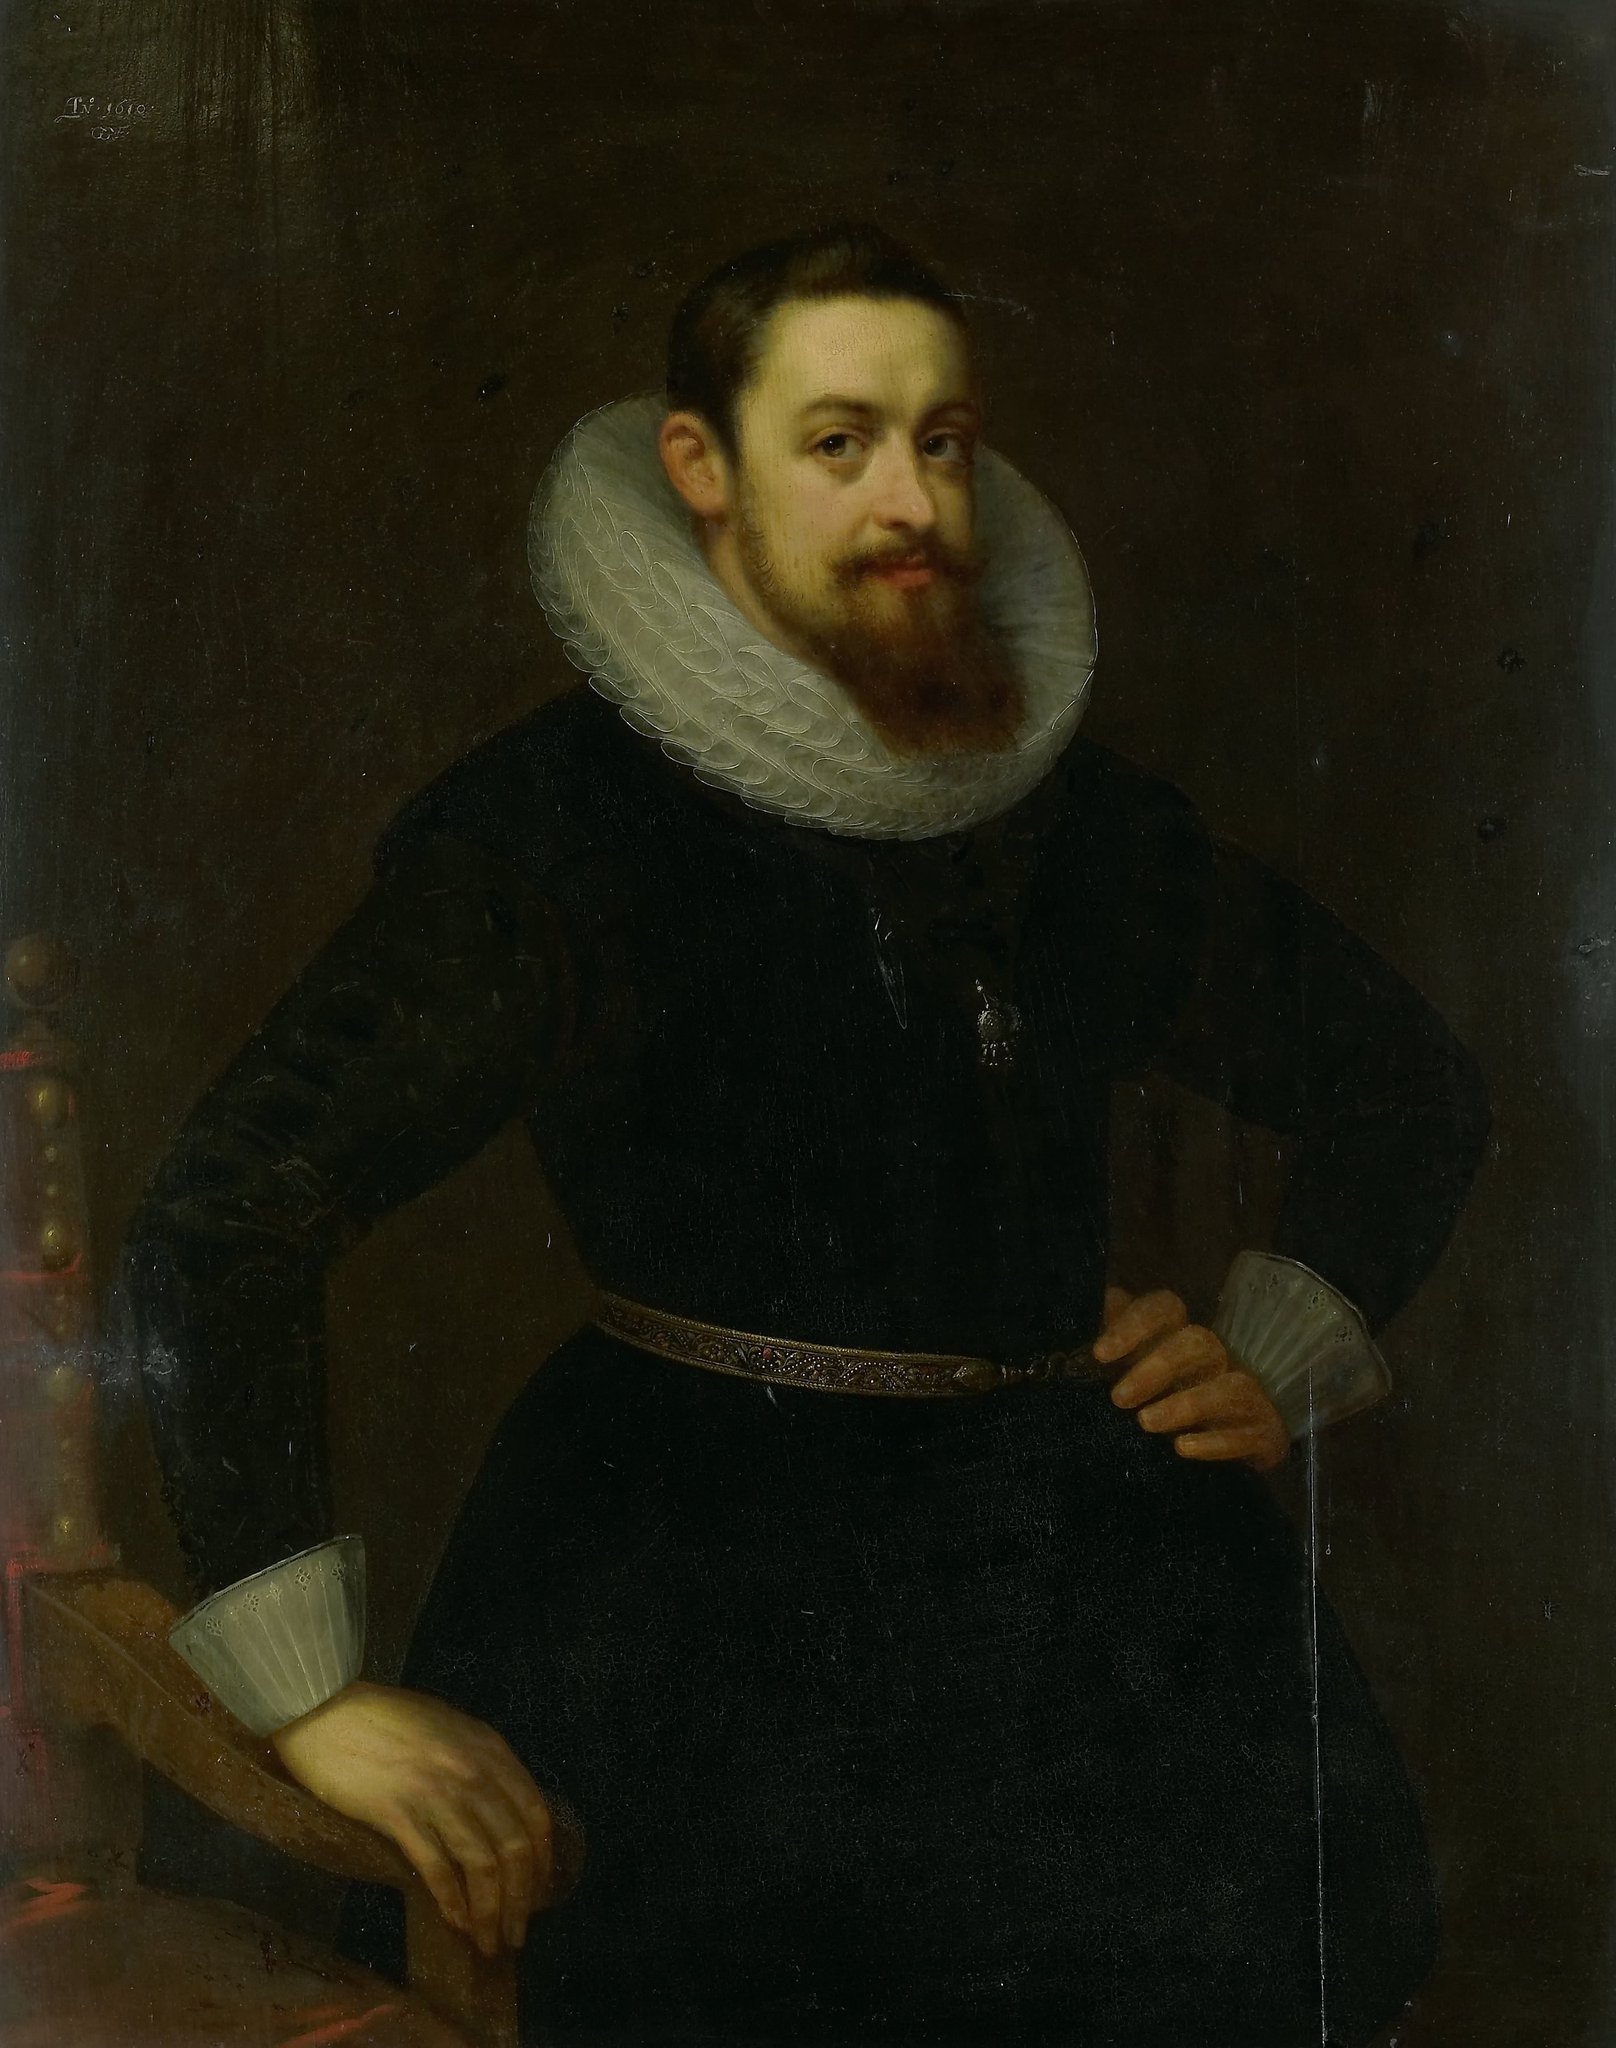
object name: painting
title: Jeremias Boudinois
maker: gortzius geldorp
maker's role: painter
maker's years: 1553-1619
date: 1610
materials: oil, panel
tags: historical persons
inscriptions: signature and date: ‘Anº 1610 GG. F.’, inscription: ‘Jeremias Boudinois. Geb: Overl: / 39’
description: Portret van Jeremias Boudinois. Staande, heupstuk, leunend met de rechterhand op de leuning van een stoel, de linkerhand in de zij. Gehuwd met Lucretia del Prado. Op de achterkant een inscriptie met de naam en het cijfer 39. Pendant van SK-A-917.